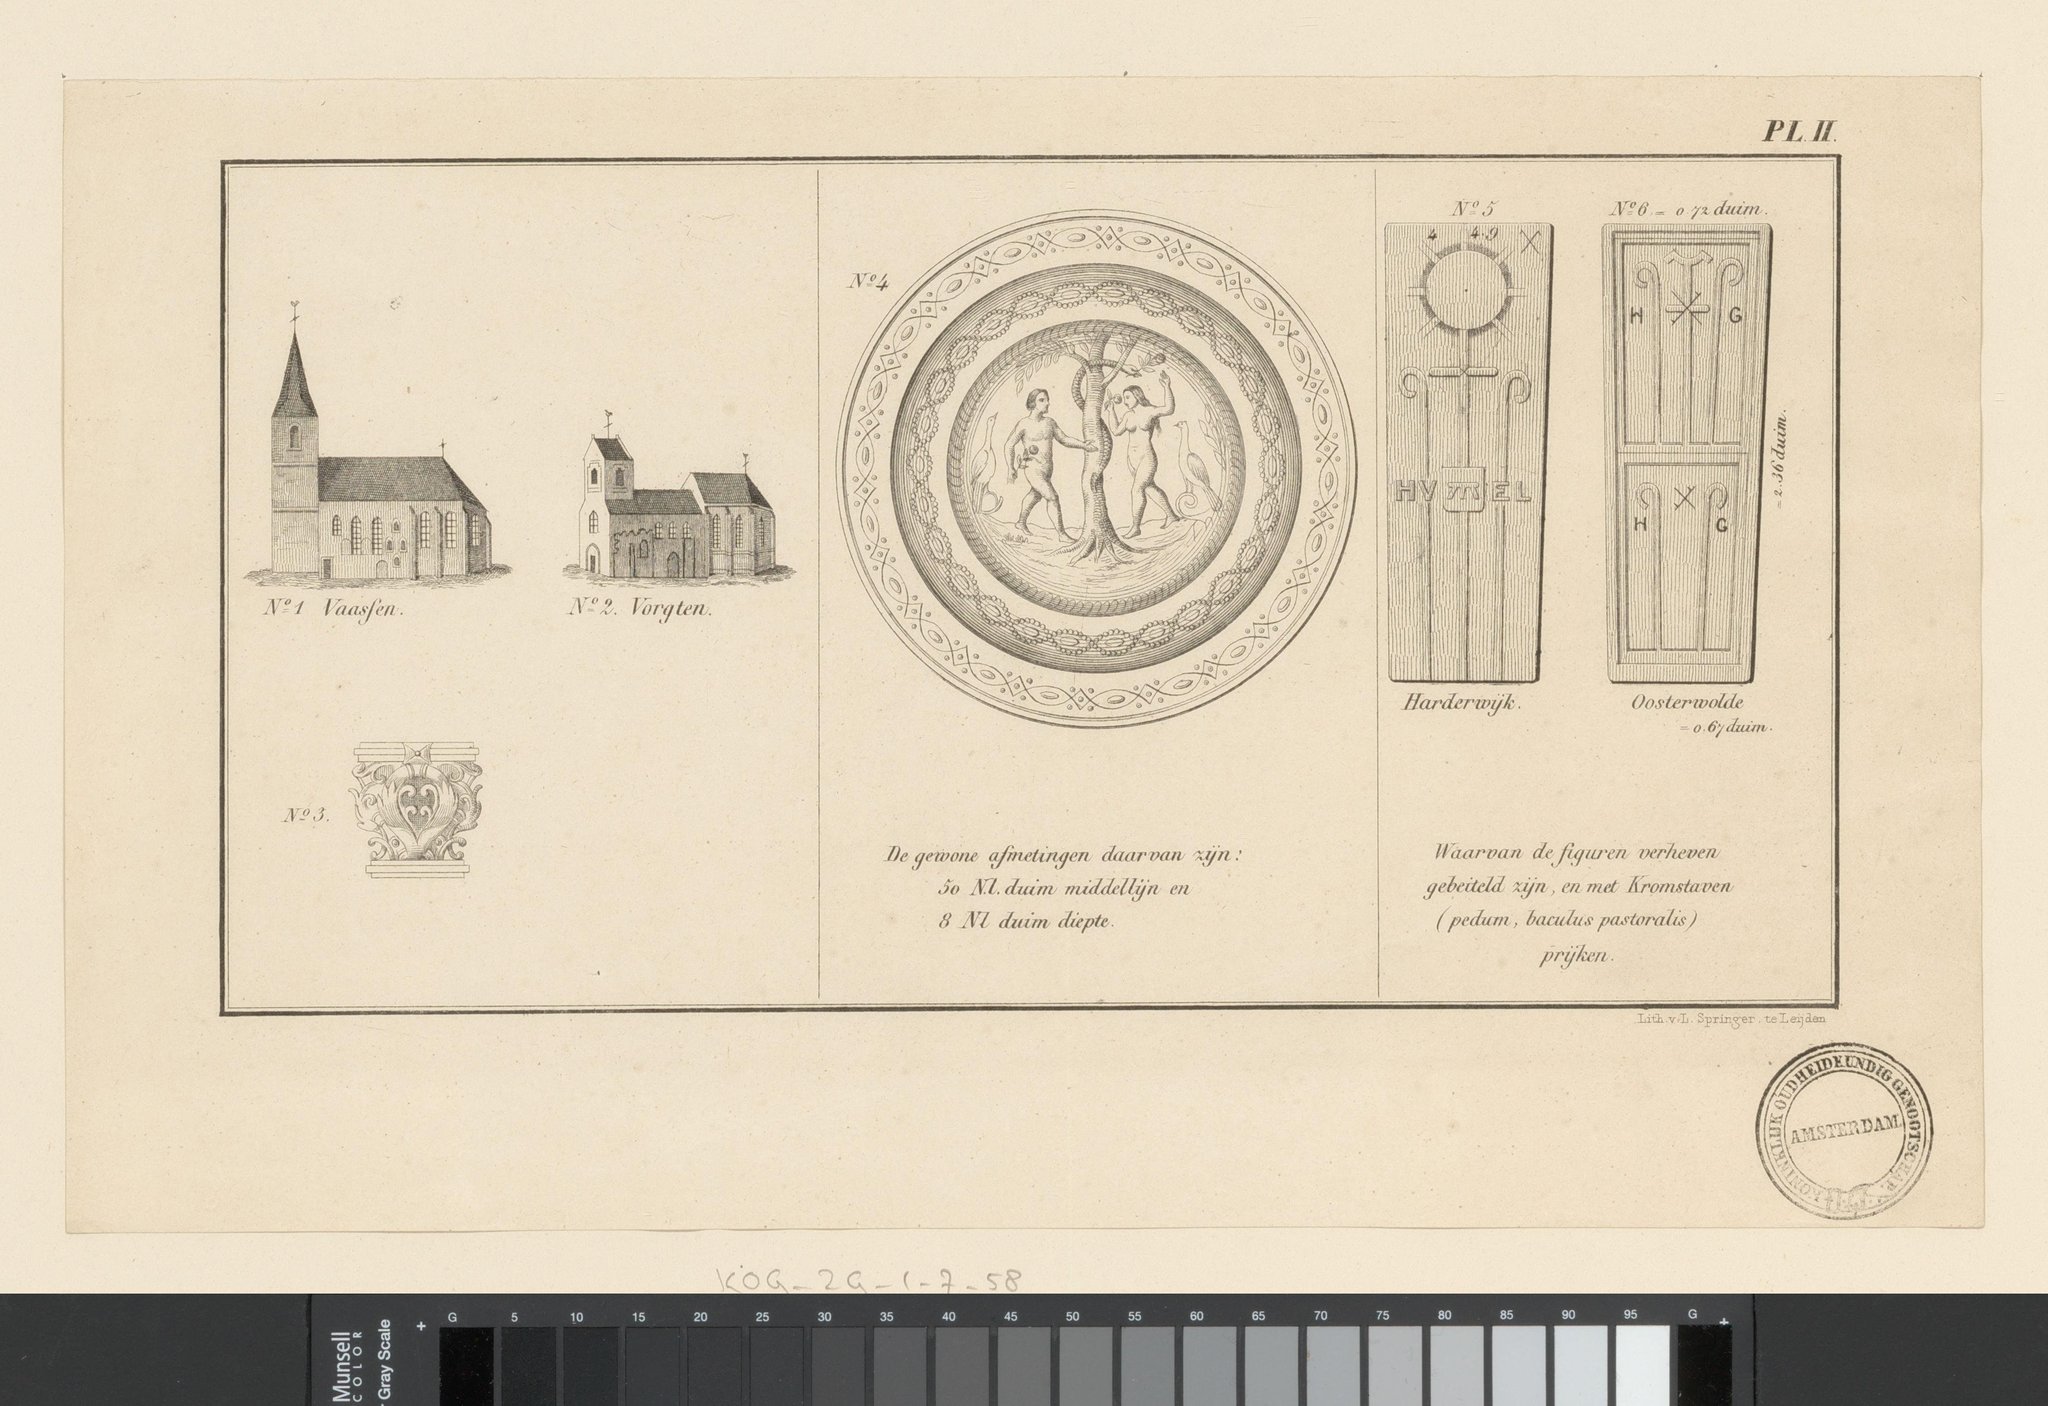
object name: print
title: Over-Veluwsche Oude kerken, Doopbekken, Grafsteenen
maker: leendert springer (i)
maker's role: draughtsman, painter, print maker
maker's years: 1789-1871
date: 1850-1852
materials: paper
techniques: lithograph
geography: leiden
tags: church (exterior), baptismal font, gravestone, tombstone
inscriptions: collector's mark: ‘Koninklijk Oudheidkundig Genootschap Amsterdam’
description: Twee kerken te Vaasen en Vorchten, een kapiteel, een doopbekken met Adam en Eva en twee grafstenen uit Harderwijk en Oosterwolde. Bij iedere afbeelding staat een nummer en de afmetingen van de verbeelde objecten op ware groten. Rechtsboven genummerd: PL. II. Onderwerpsrubrieken binnen de Atlas Zeden en Gewoonten: Godsdienst, Roomsch-Katholieken, Processies, Herinneringen.